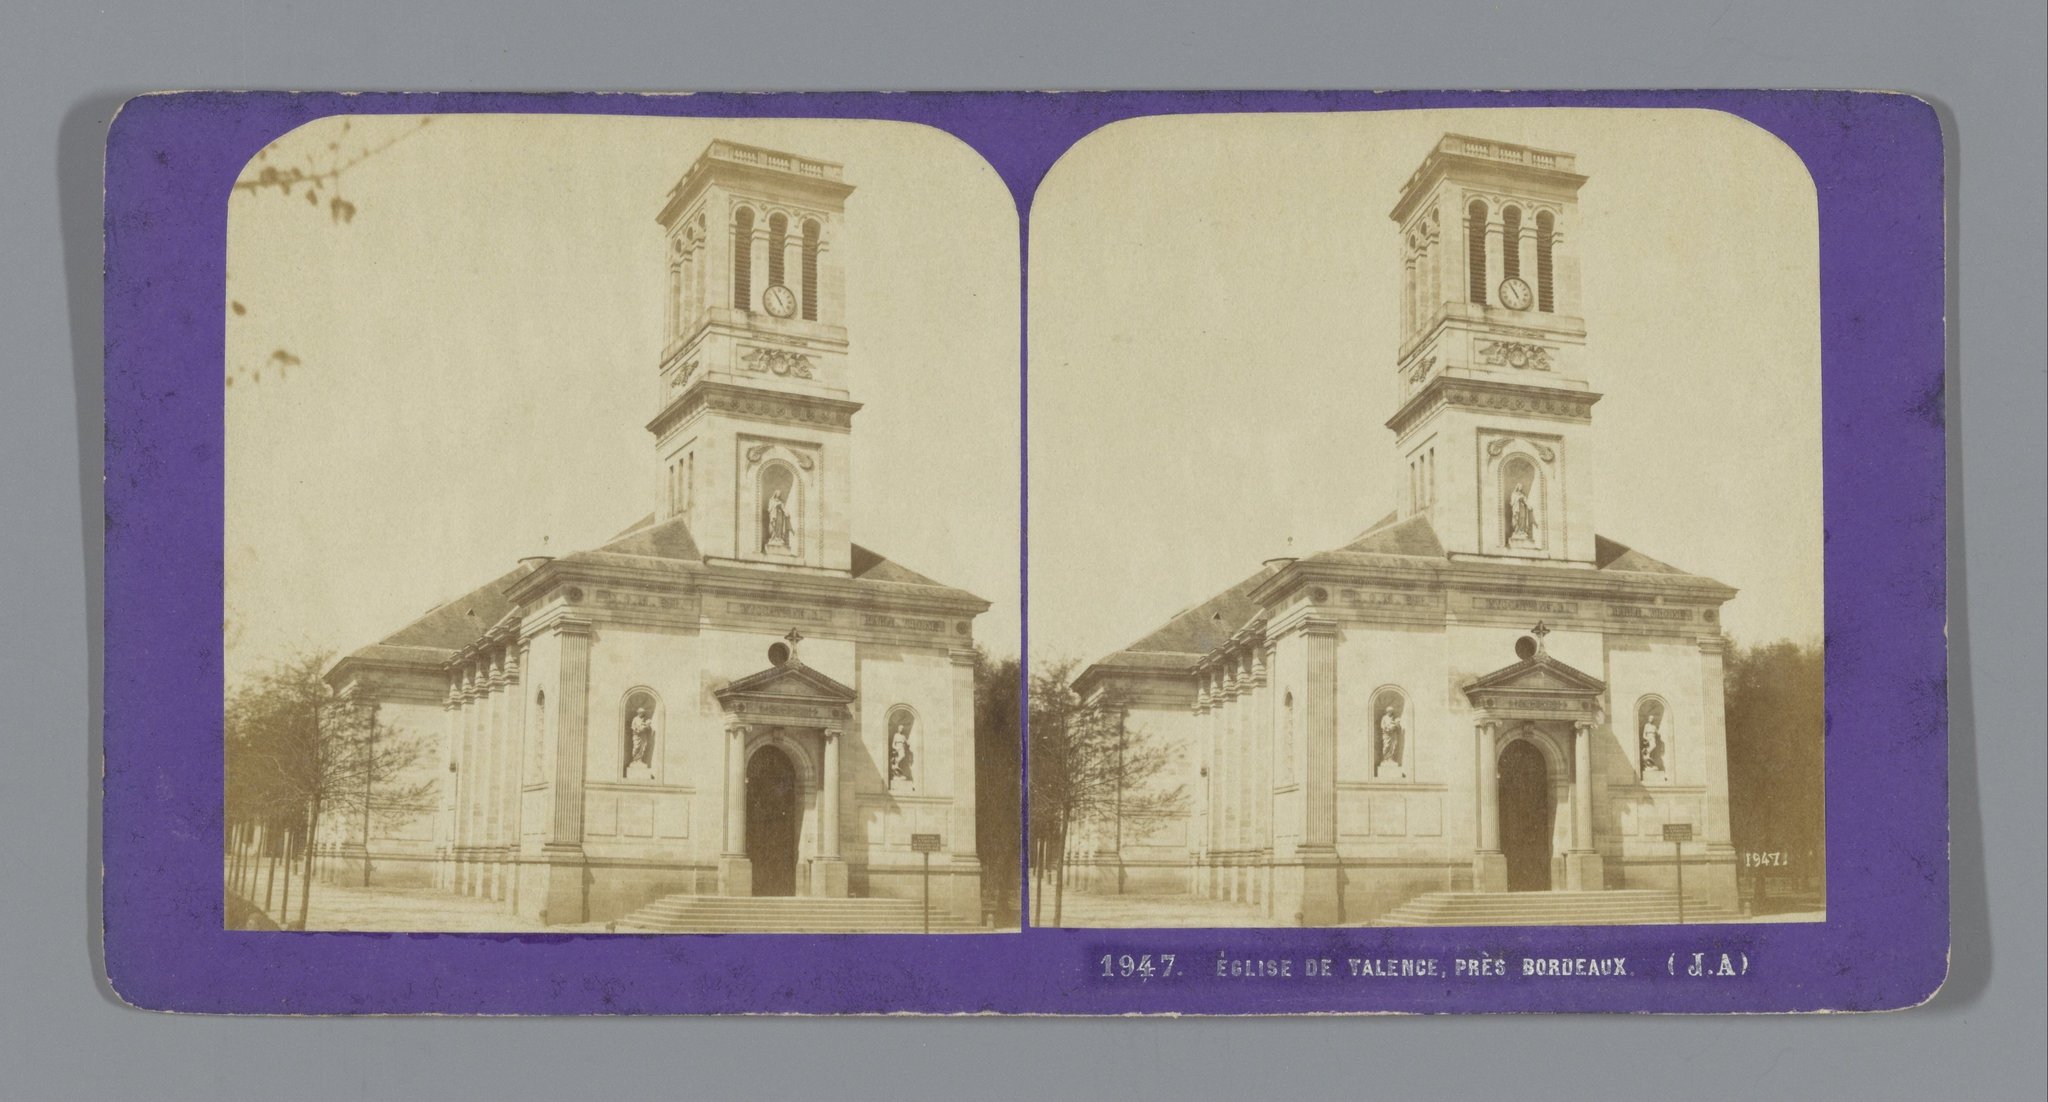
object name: stereograph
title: Exterieur van een kerk (vermoedelijk) te Valence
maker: jean andrieu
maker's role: fotograaf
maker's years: 1816-1872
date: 1862-1876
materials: cardboard, photographic support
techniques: albumen print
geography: valence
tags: church (exterior), façade (of house or building)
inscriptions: number: ‘1947’